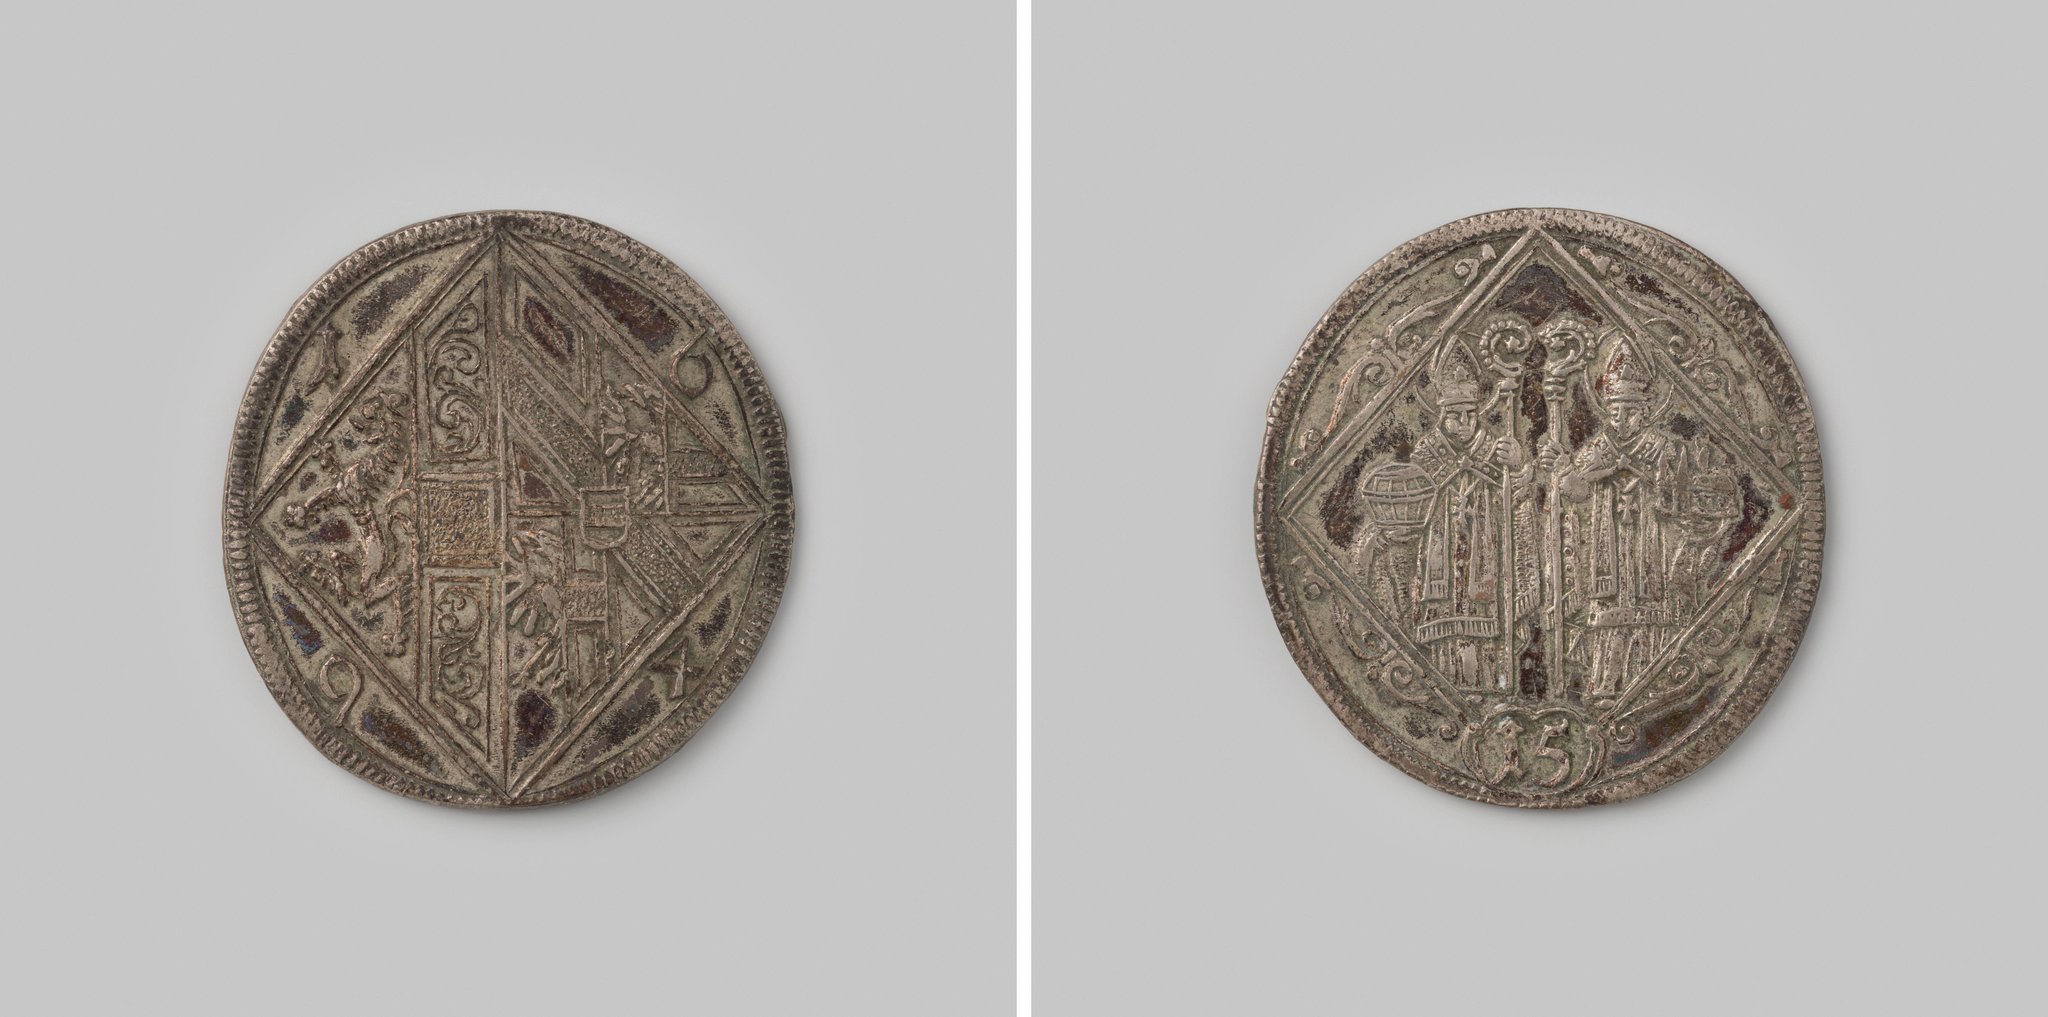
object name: coin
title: Aartsbisdom Salzburg, Johann Ernst von Thun, 15 kreuzer,1694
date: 1694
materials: silver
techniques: striking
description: Zilveren munt. Voorzijde: wapenschild in ruitvorm. In de vier uitsparingen de vier cijfers van het jaartal. Keerzijde: binnen versierde ruit de heiligen Rupert en Virgil met mijter en staf naar elkaar toegewend. Waarde-aanduiding: 15 in versiering onderaan.